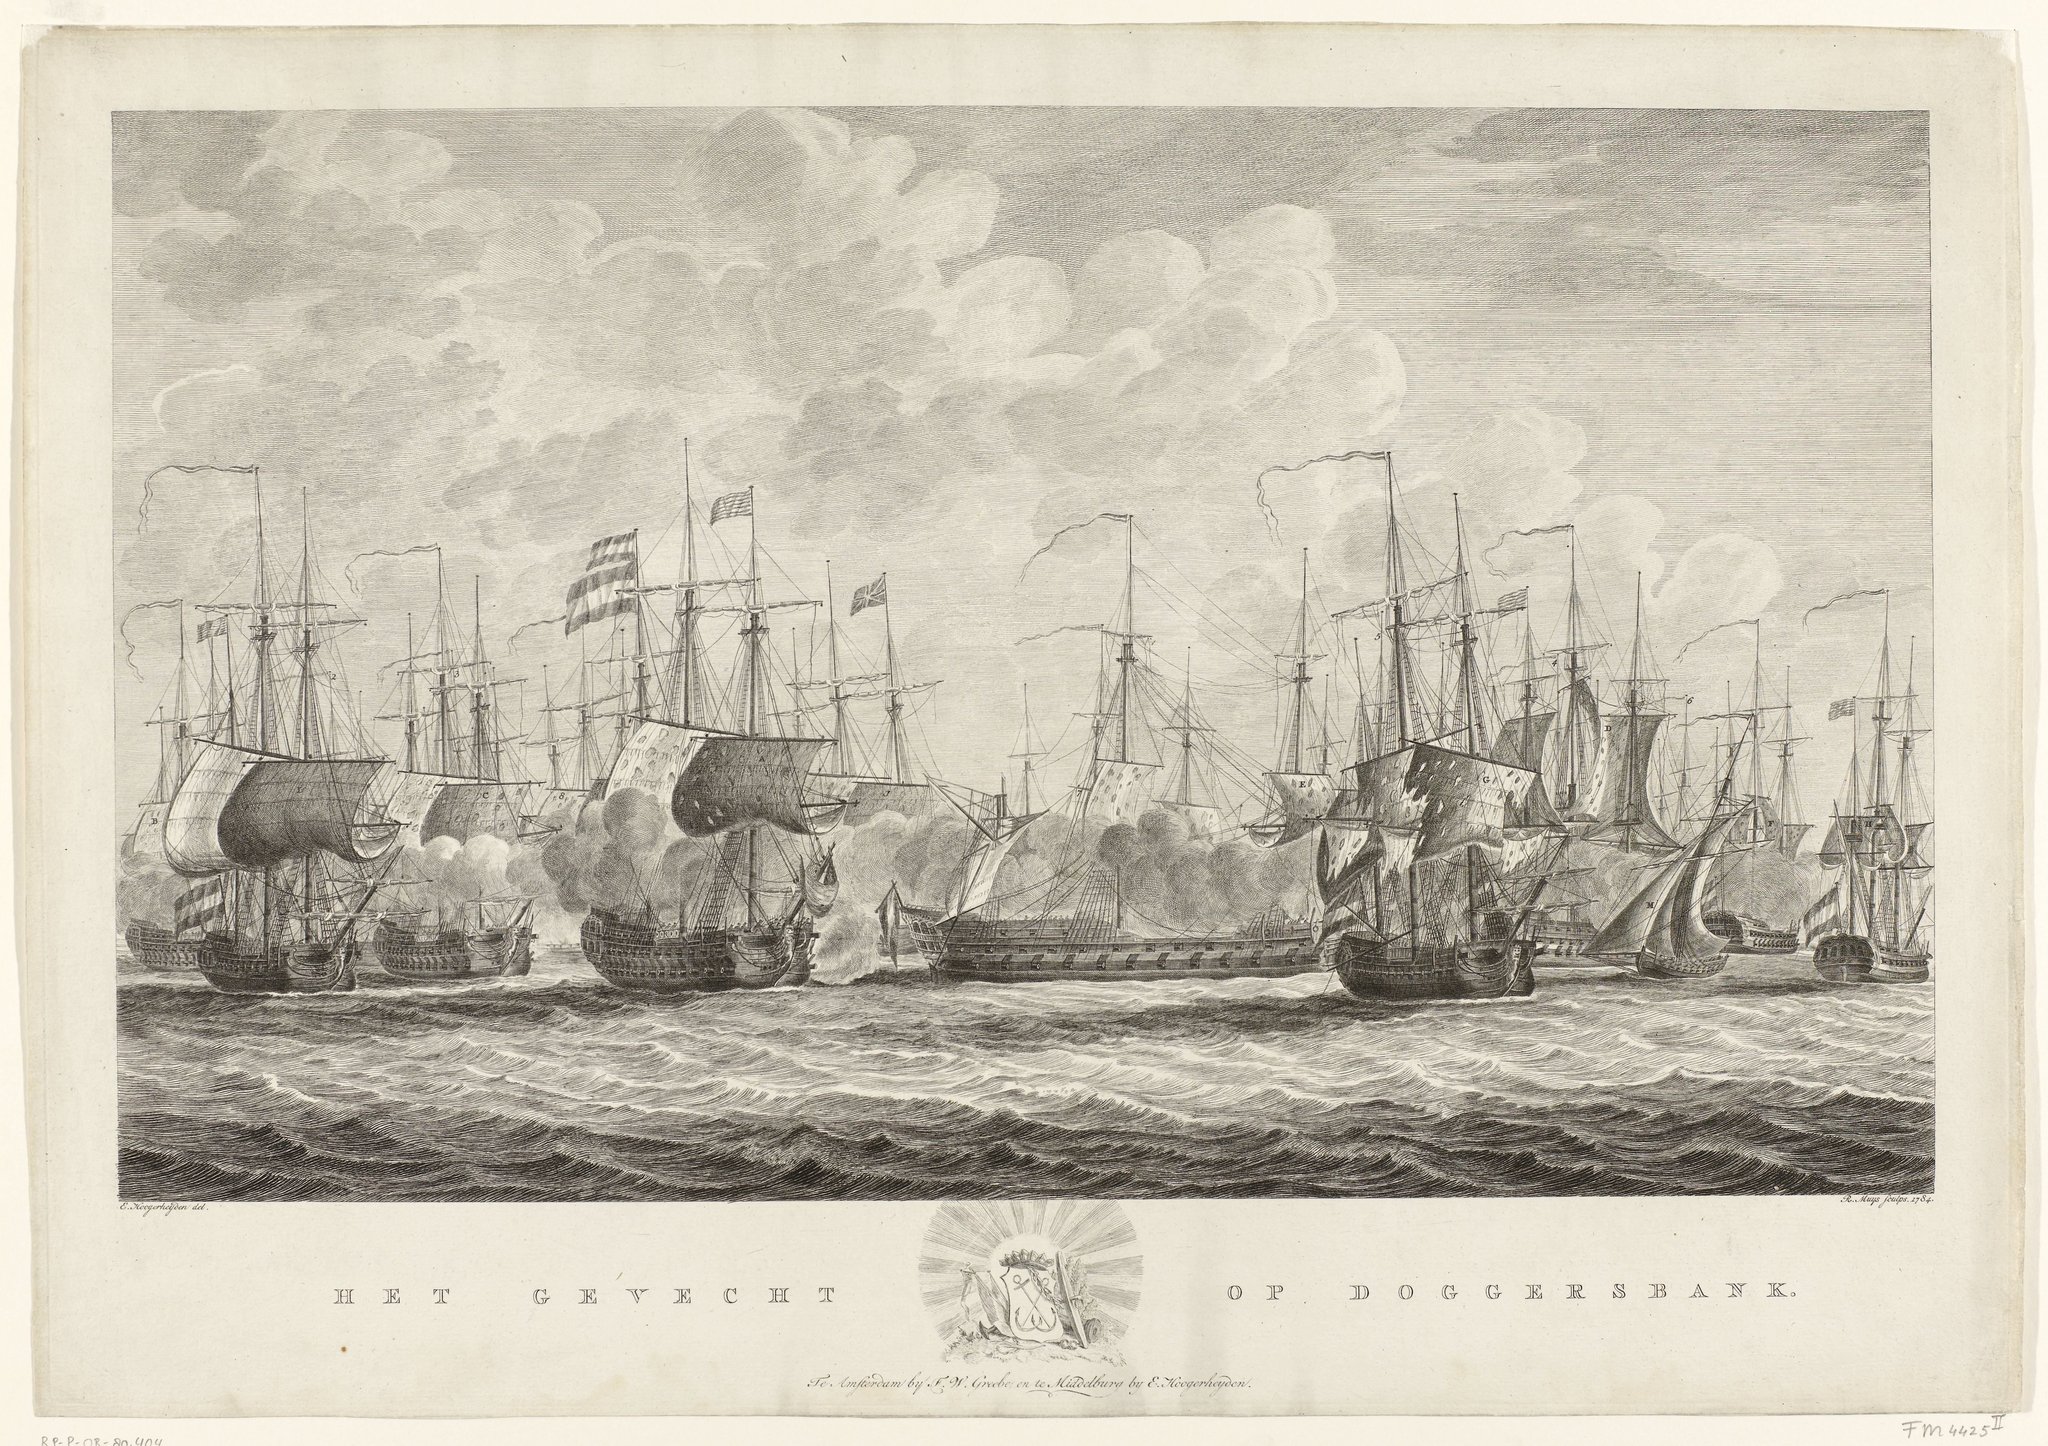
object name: print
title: Het gevecht op Doggersbank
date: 1784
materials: paper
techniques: engraving, etching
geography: middelburg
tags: johan arnold zoutman, hyde parker, battle (+ naval force)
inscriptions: collector's mark: Lugt 2228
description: De Nederlandse en Engelse schepen in gevecht tijdens de zeeslag bij Doggersbank op 5 augustus 1781 tussen de Nederlandse vloot onder schout-bij-nacht Johan Zoutman en de Engelse vloot onder vice-admiraal Hyde Parker. Onderdeel van een serie van vier platen van de Zeeslag op de Doggersbank.